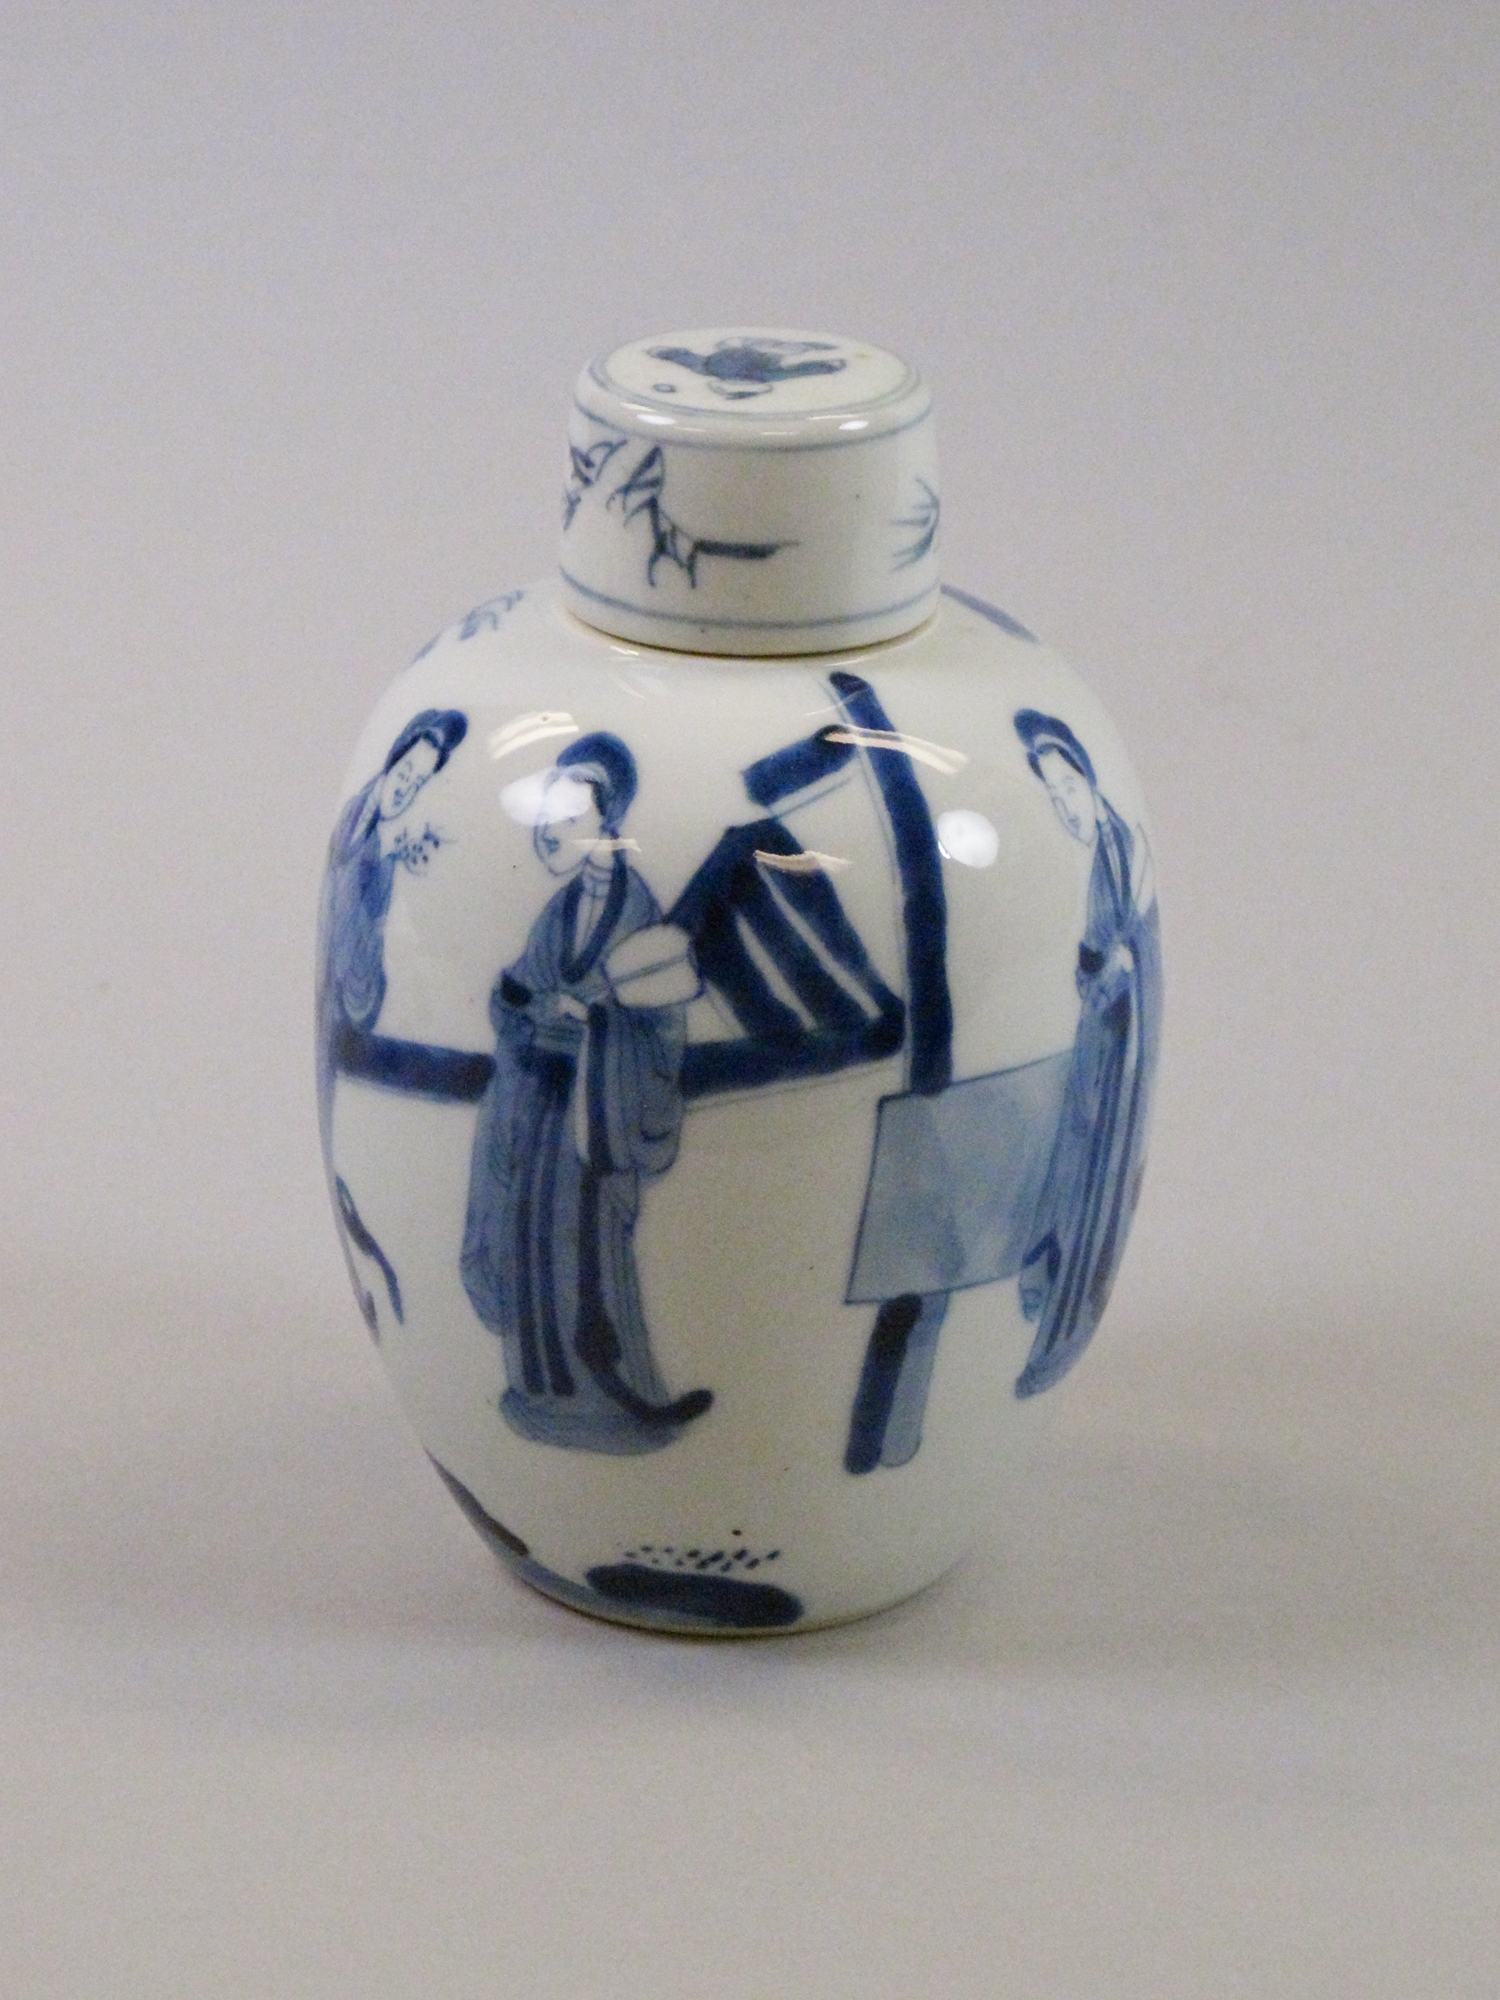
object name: covered jar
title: Tea leaf jar with ladies at leisure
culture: chinese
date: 1667-1733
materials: cobalt, porcelain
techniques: painting, underglaze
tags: women